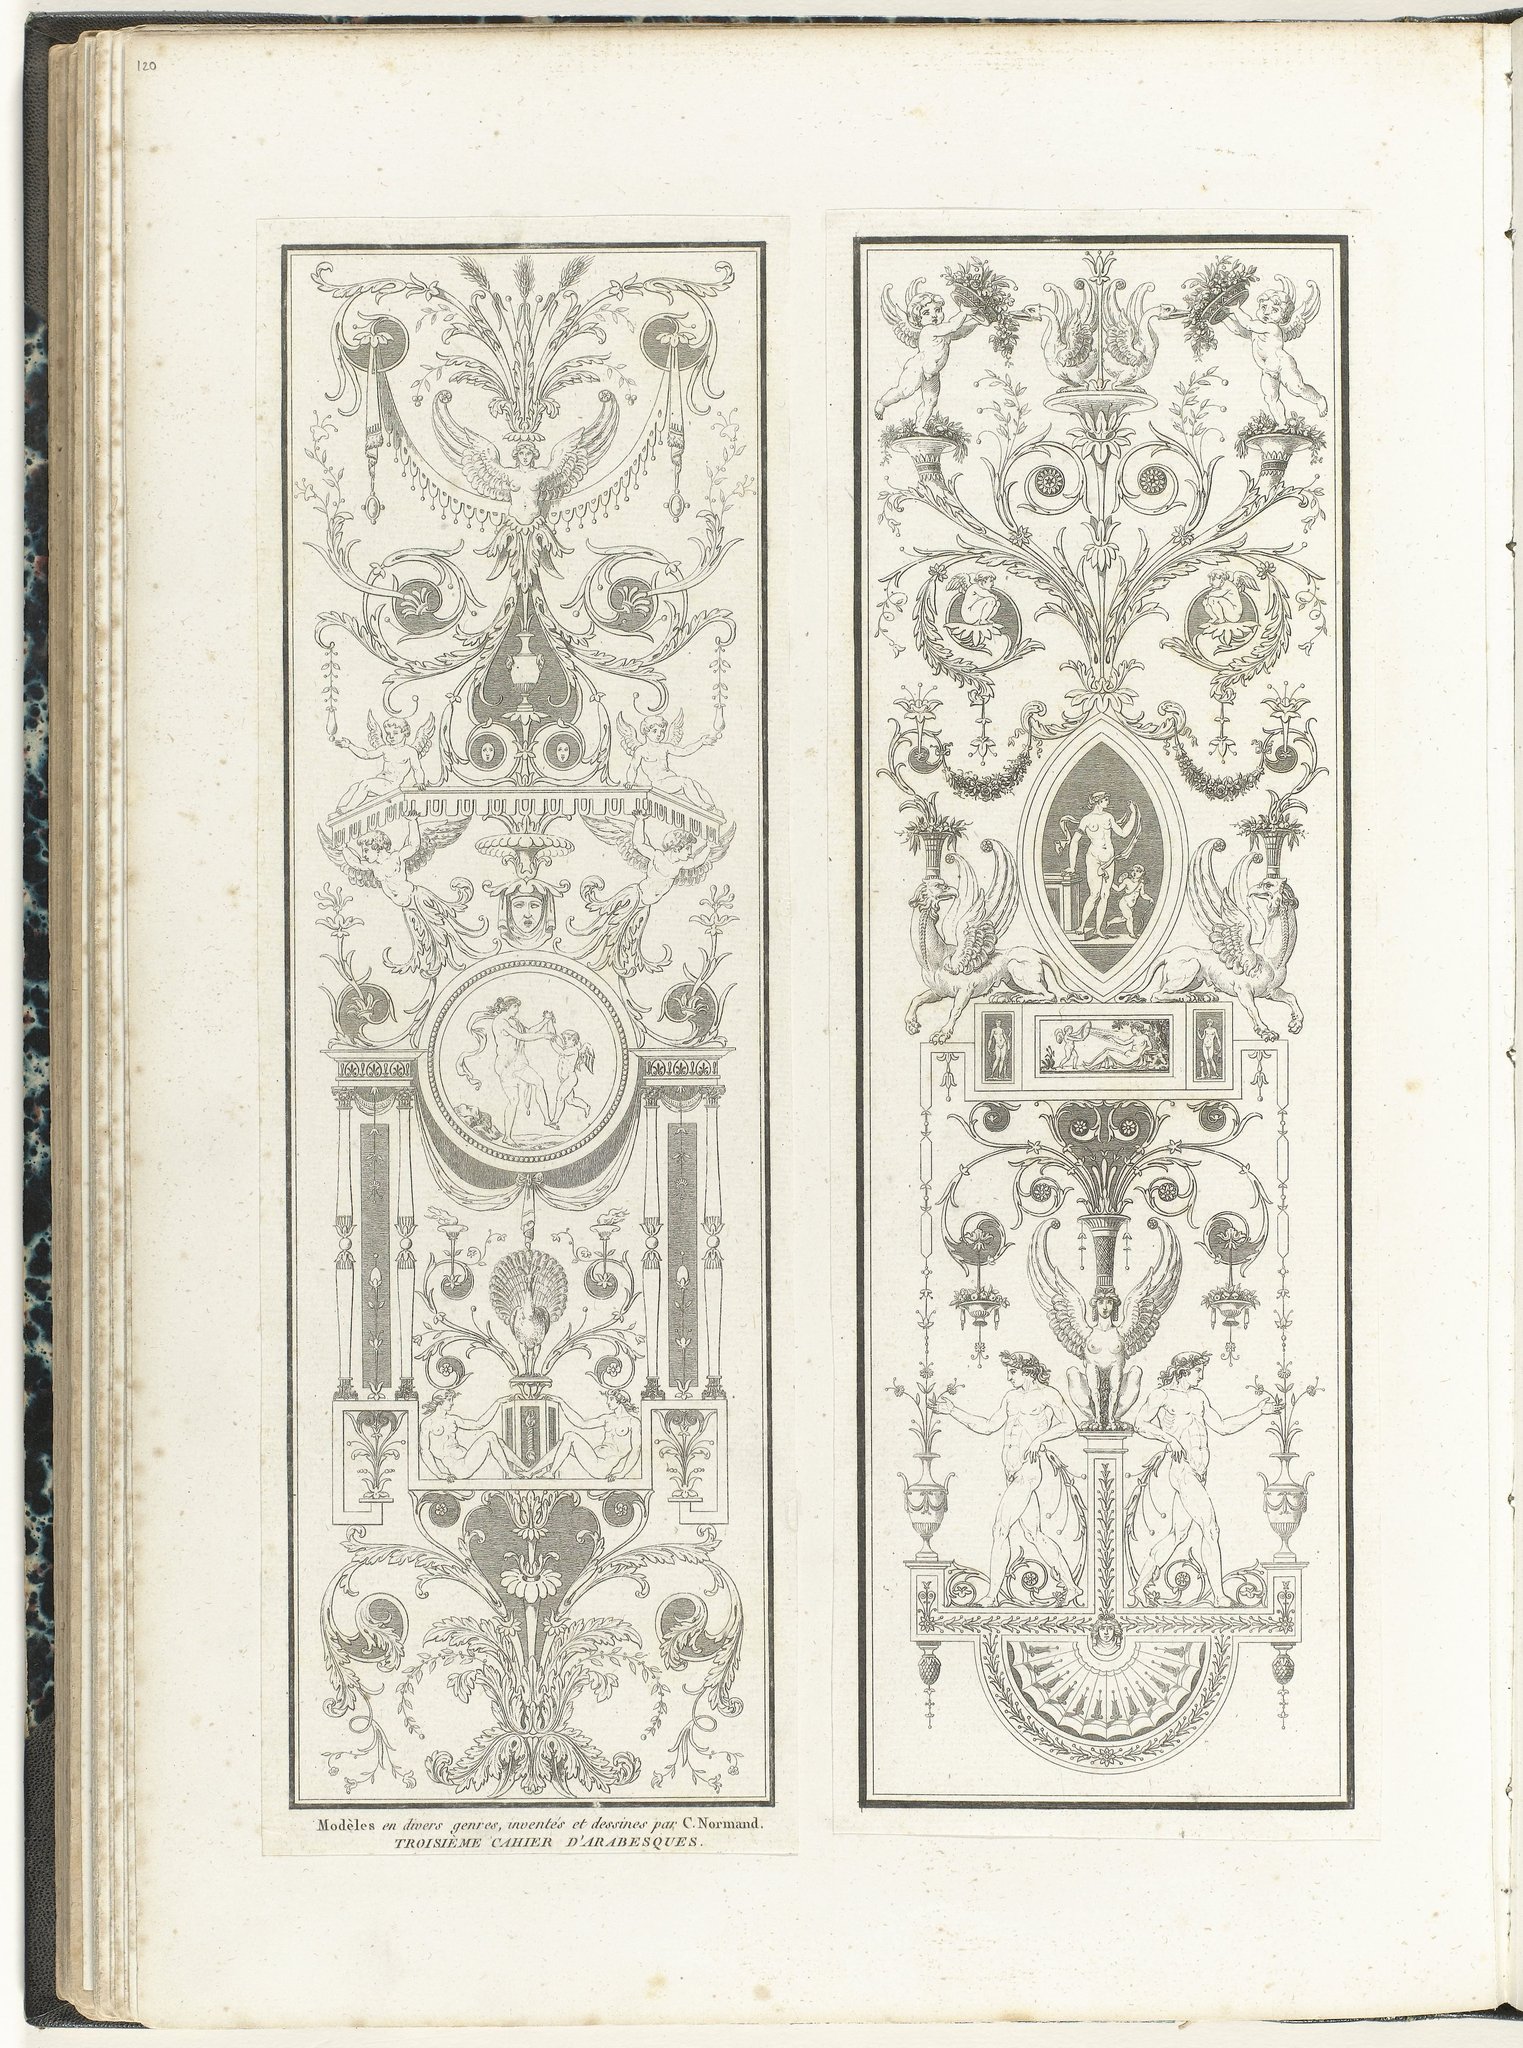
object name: print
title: Troisième Cahier d'Arabesques.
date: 1866-1900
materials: paper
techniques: lithograph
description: Op het linkerpaneel hangt in het midden een medaillon met een dansende vrouw en putto, op het rechterpaneel hangt in het midden een puntig ovaal medaillon met Venus en Amor.